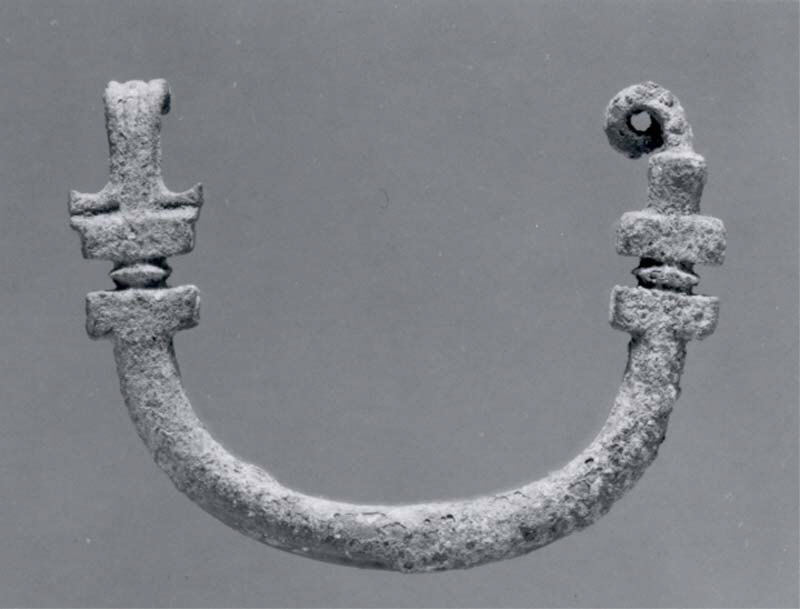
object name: fibula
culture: phrygian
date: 800-601 BCE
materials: bronze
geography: phrygia